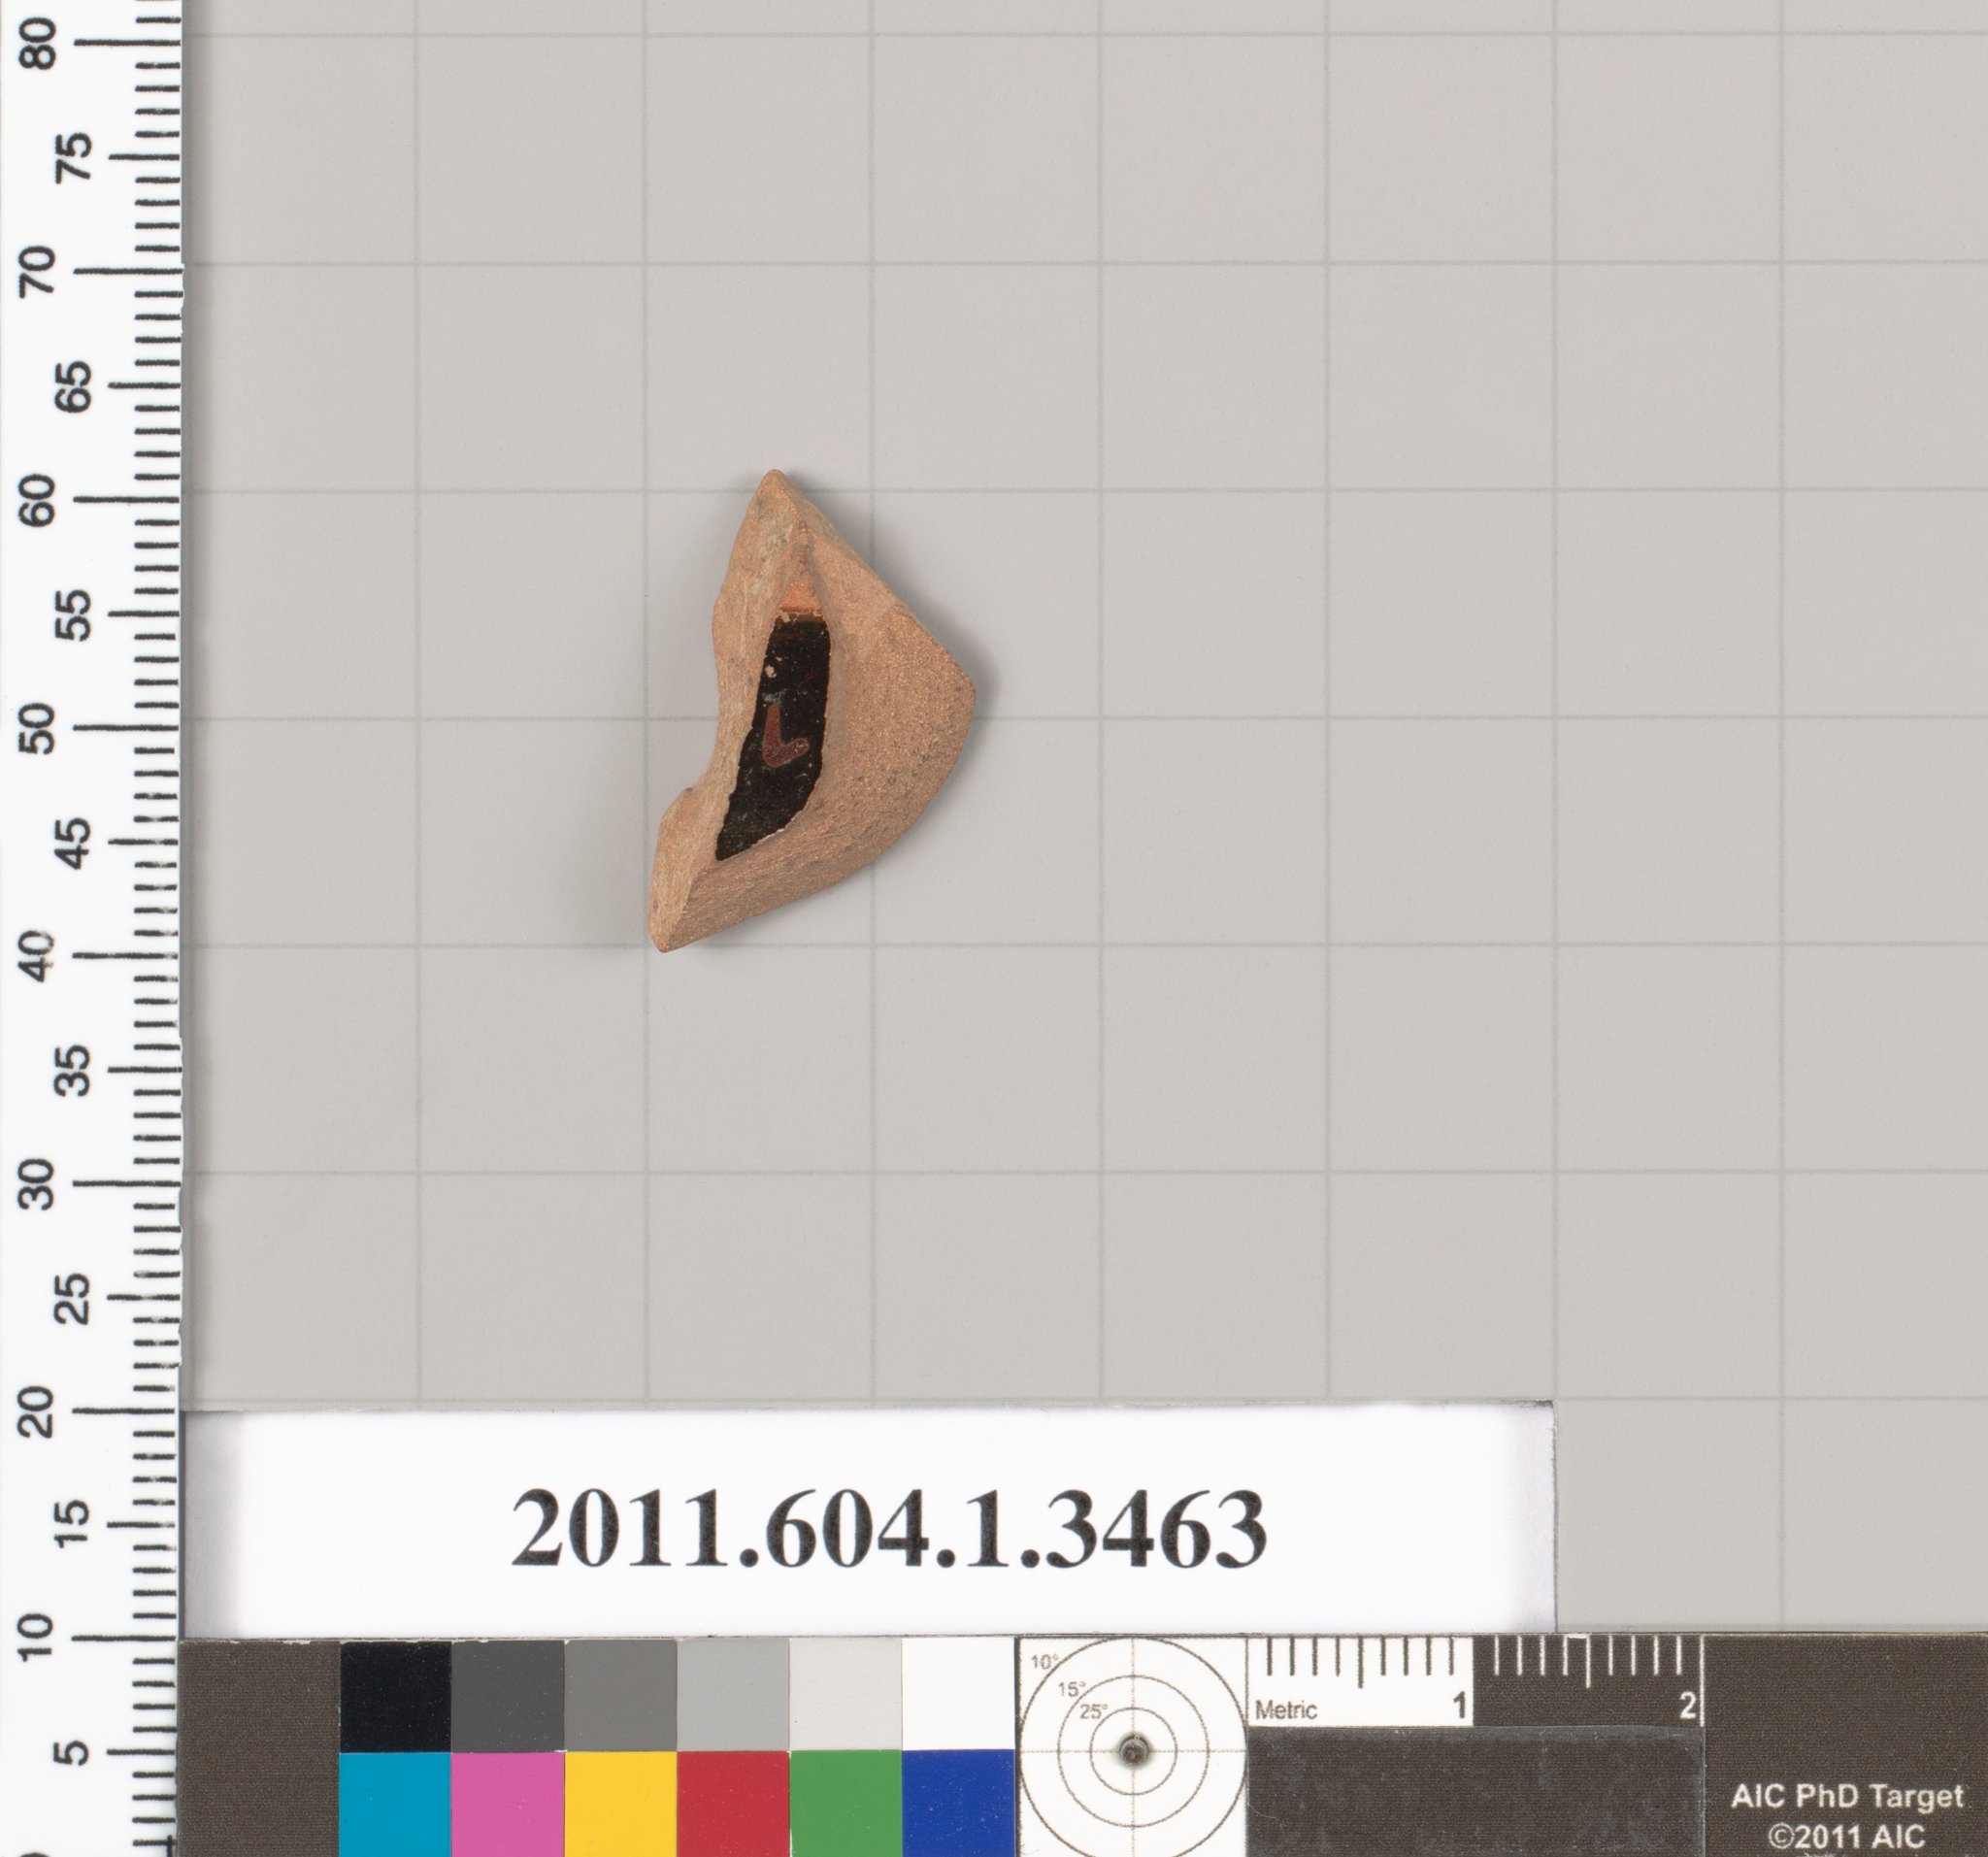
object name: kylix fragment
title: Terracotta fragment of a kylix (drinking cup)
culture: greek, attic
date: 500-470 BCE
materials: terracotta